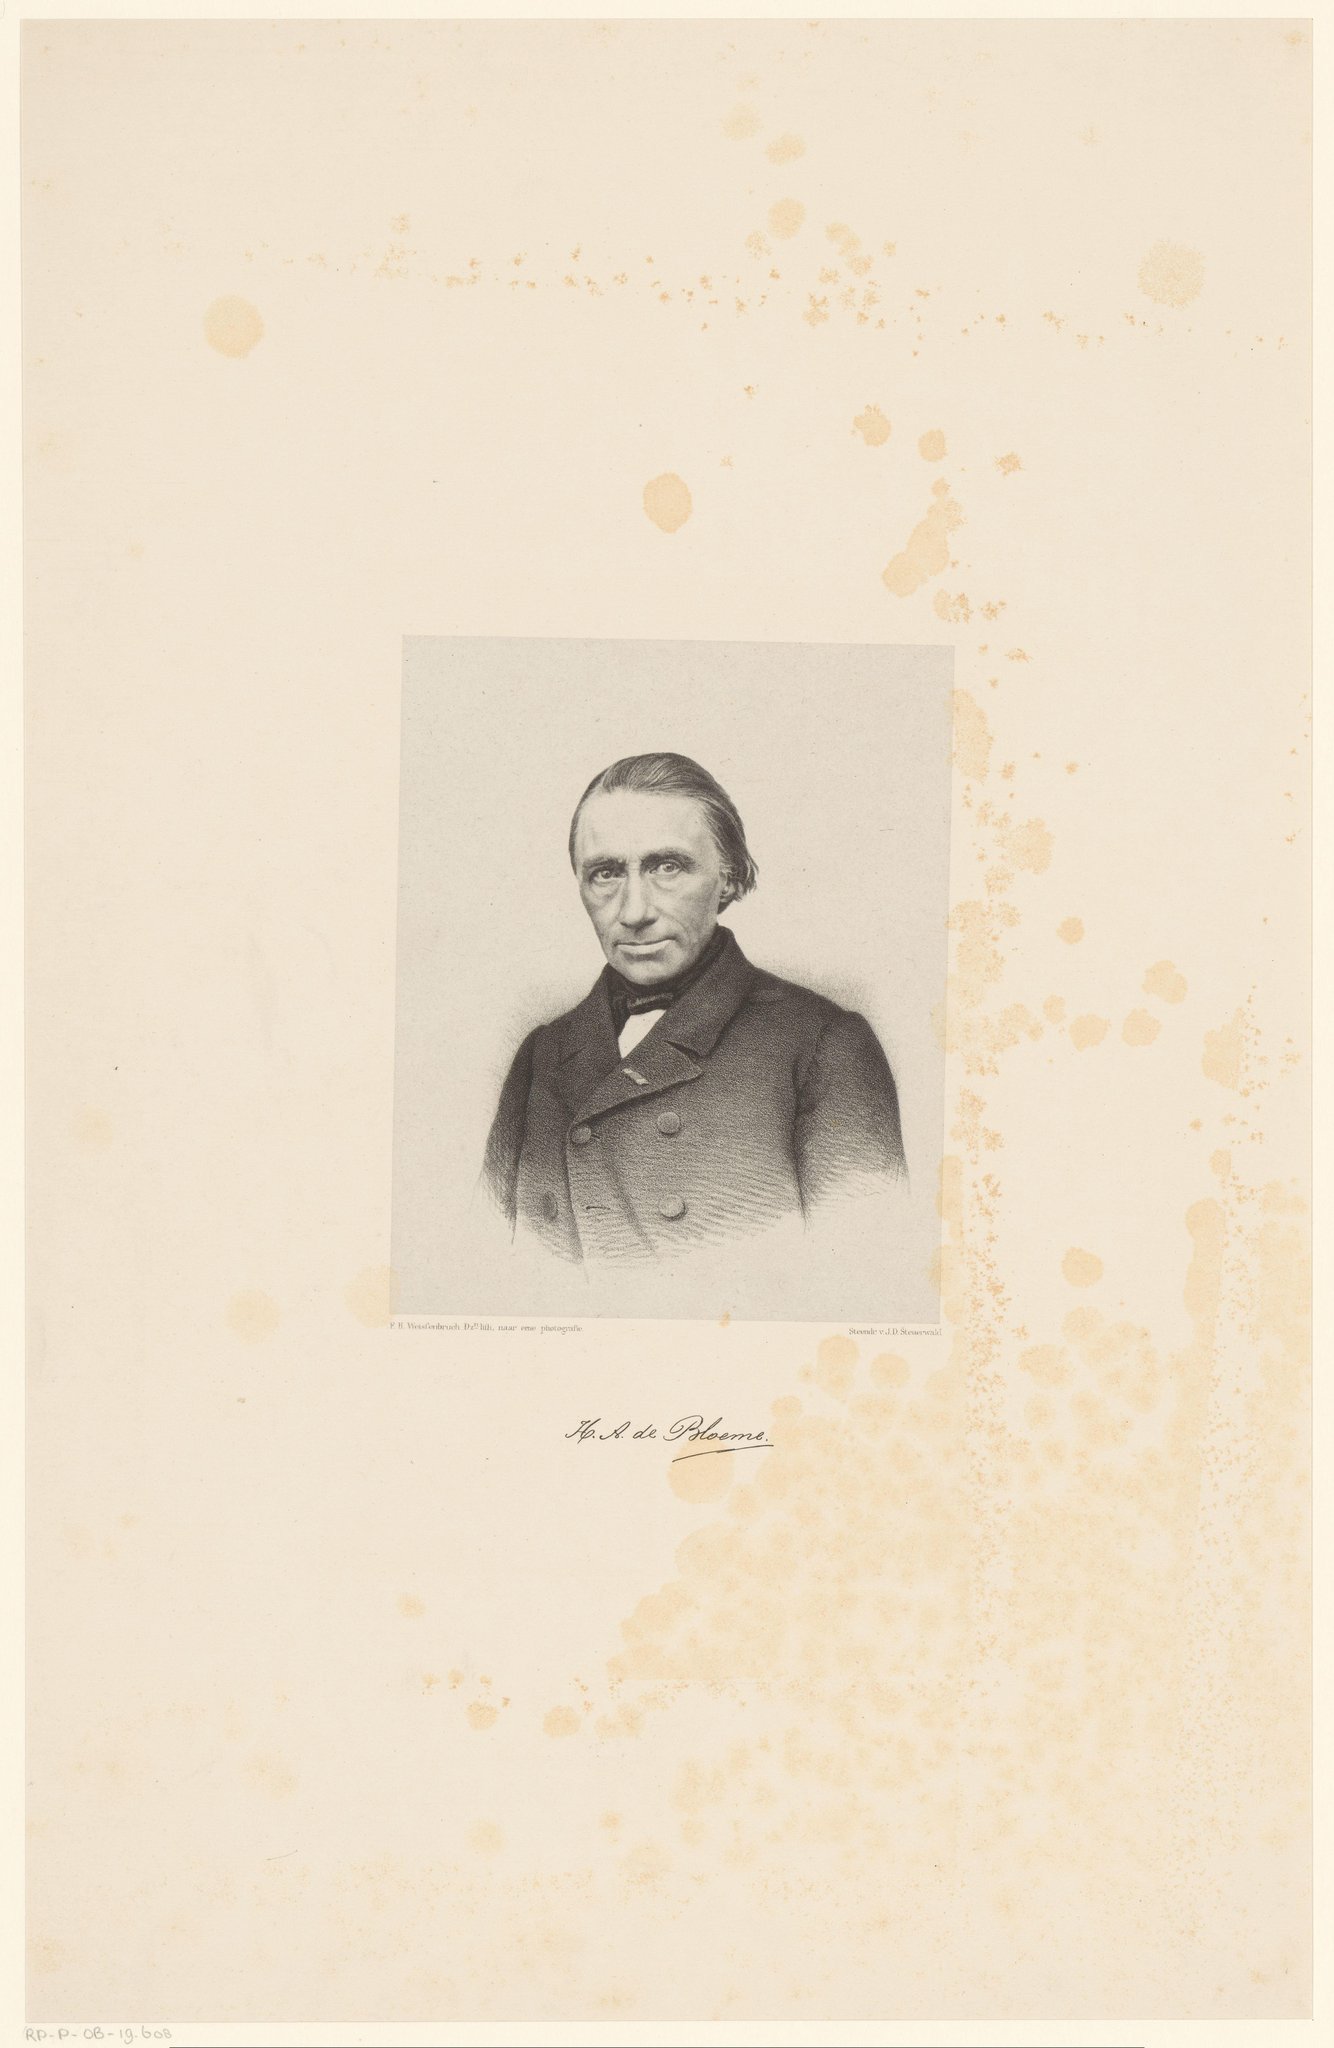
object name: print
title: Portret van Herman Antonie de Bloeme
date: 1838-1863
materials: paper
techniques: lithograph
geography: the hague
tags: painter, print maker, herman antonie de bloeme, historical persons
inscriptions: collector's mark: Lugt 2228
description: Onder het portret de signatuur van de geportretteerde.